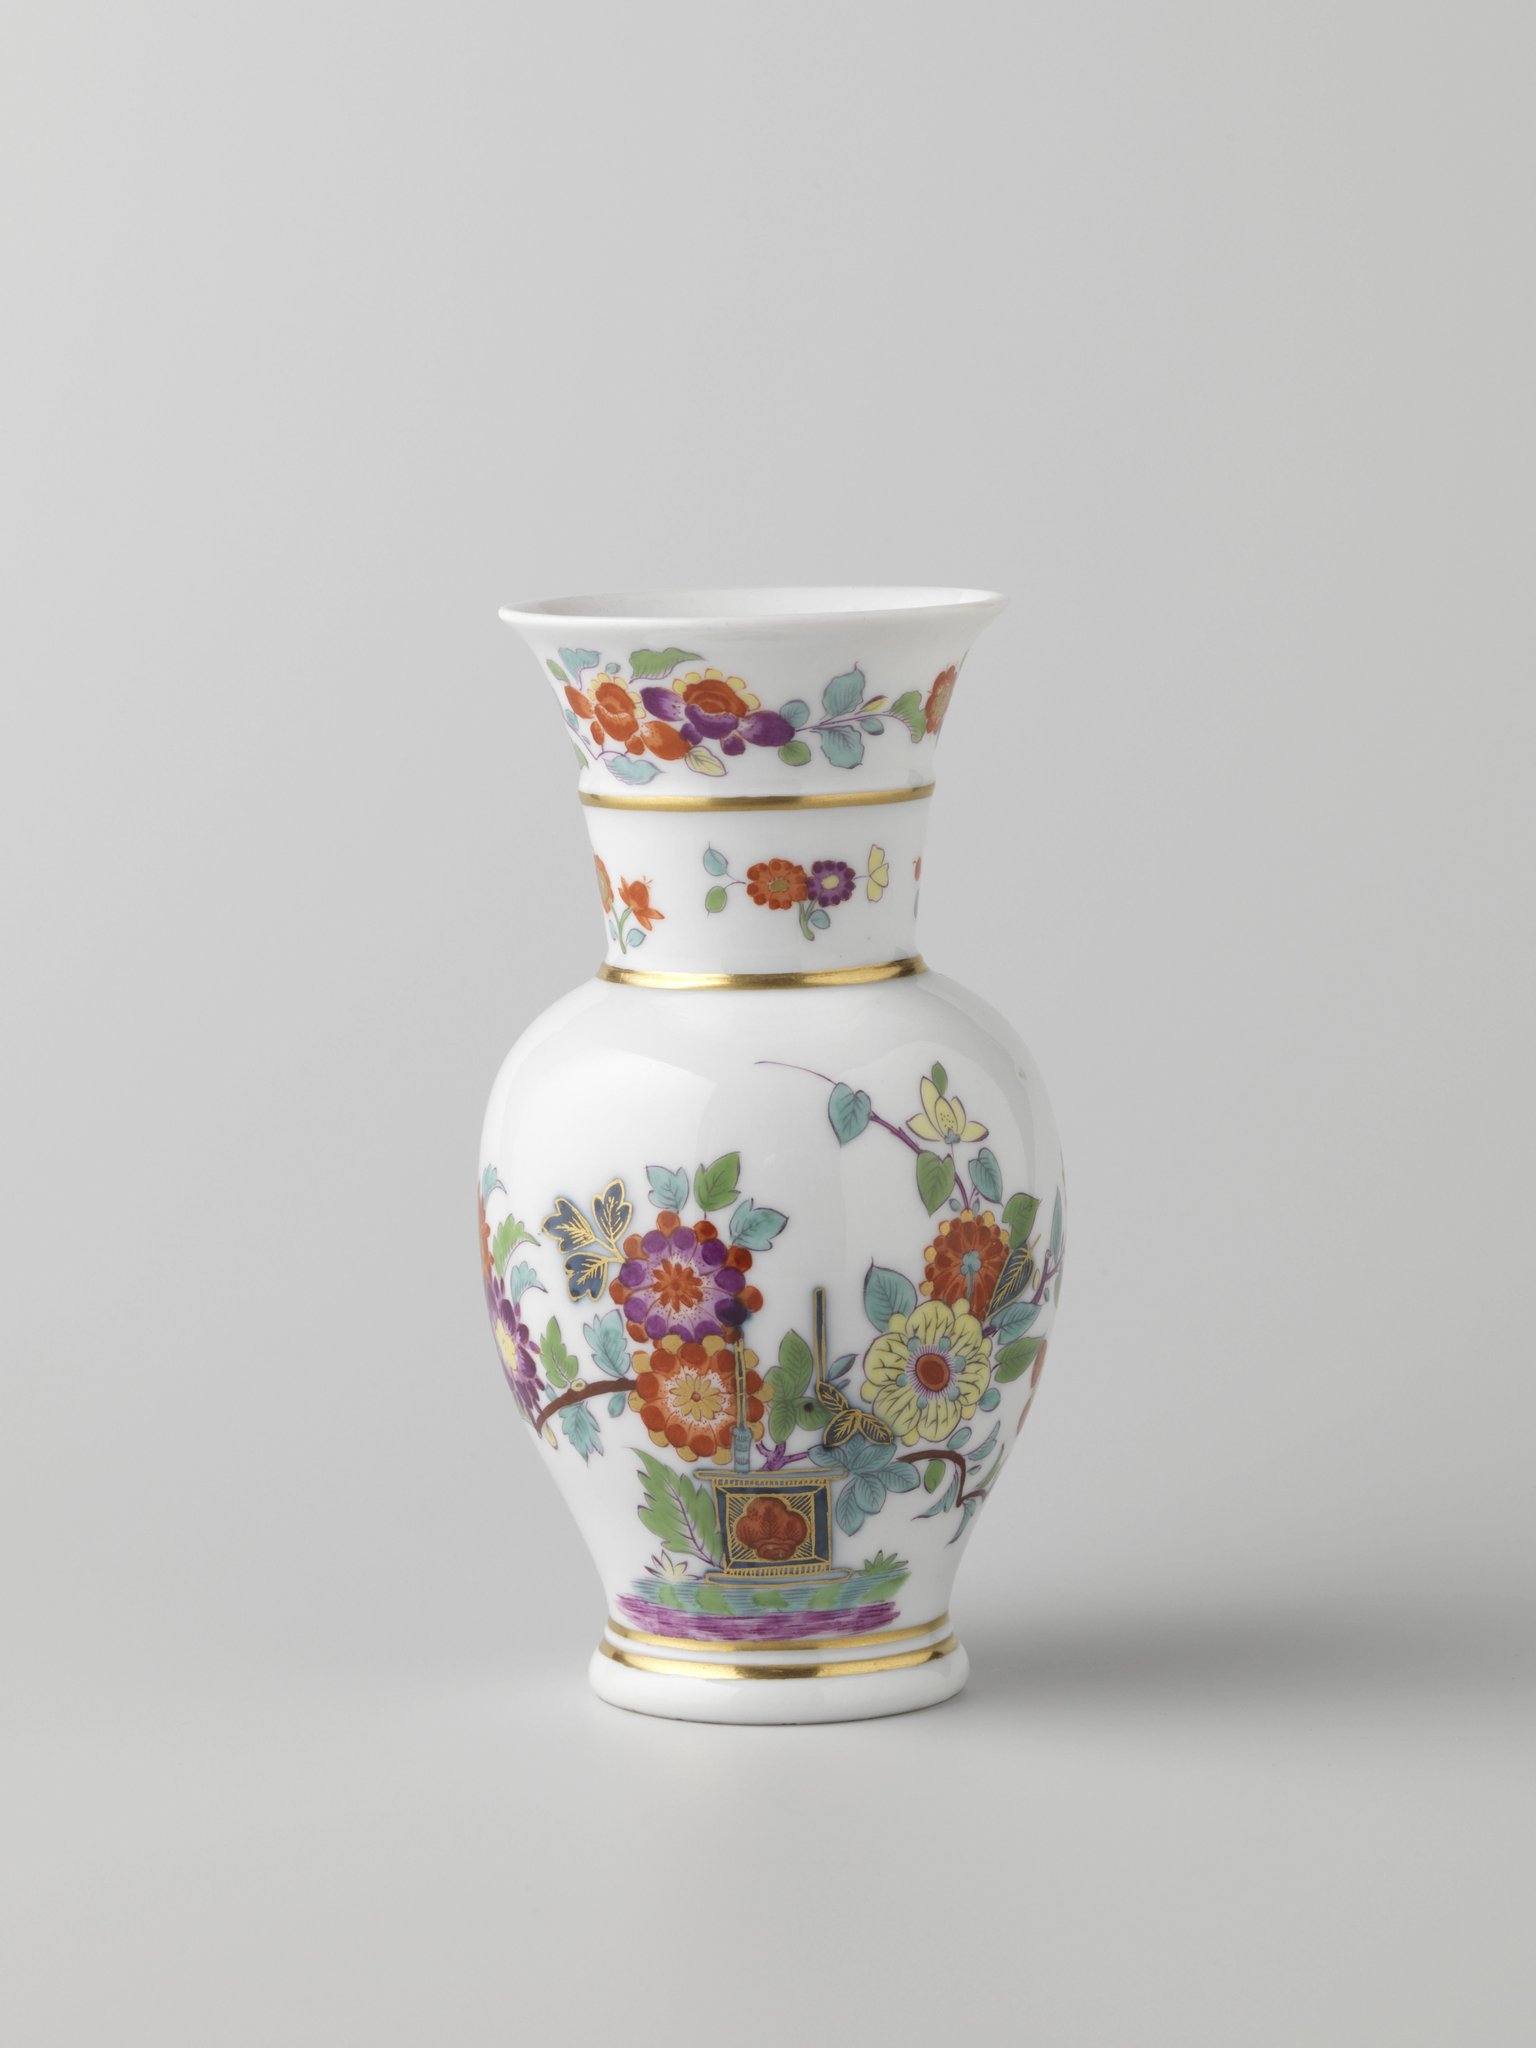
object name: vase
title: Vaas, veelkleurig beschilderd met Indianische Blumen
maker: johann daniel rehschuh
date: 1730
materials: porcelain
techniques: painted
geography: meissen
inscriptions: mold mark: ‘X (Rückert 1996, afb. 6, nr. 33)’, factory mark: ‘AR’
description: Two vases. Porcelain. Meissen, c. 1730.